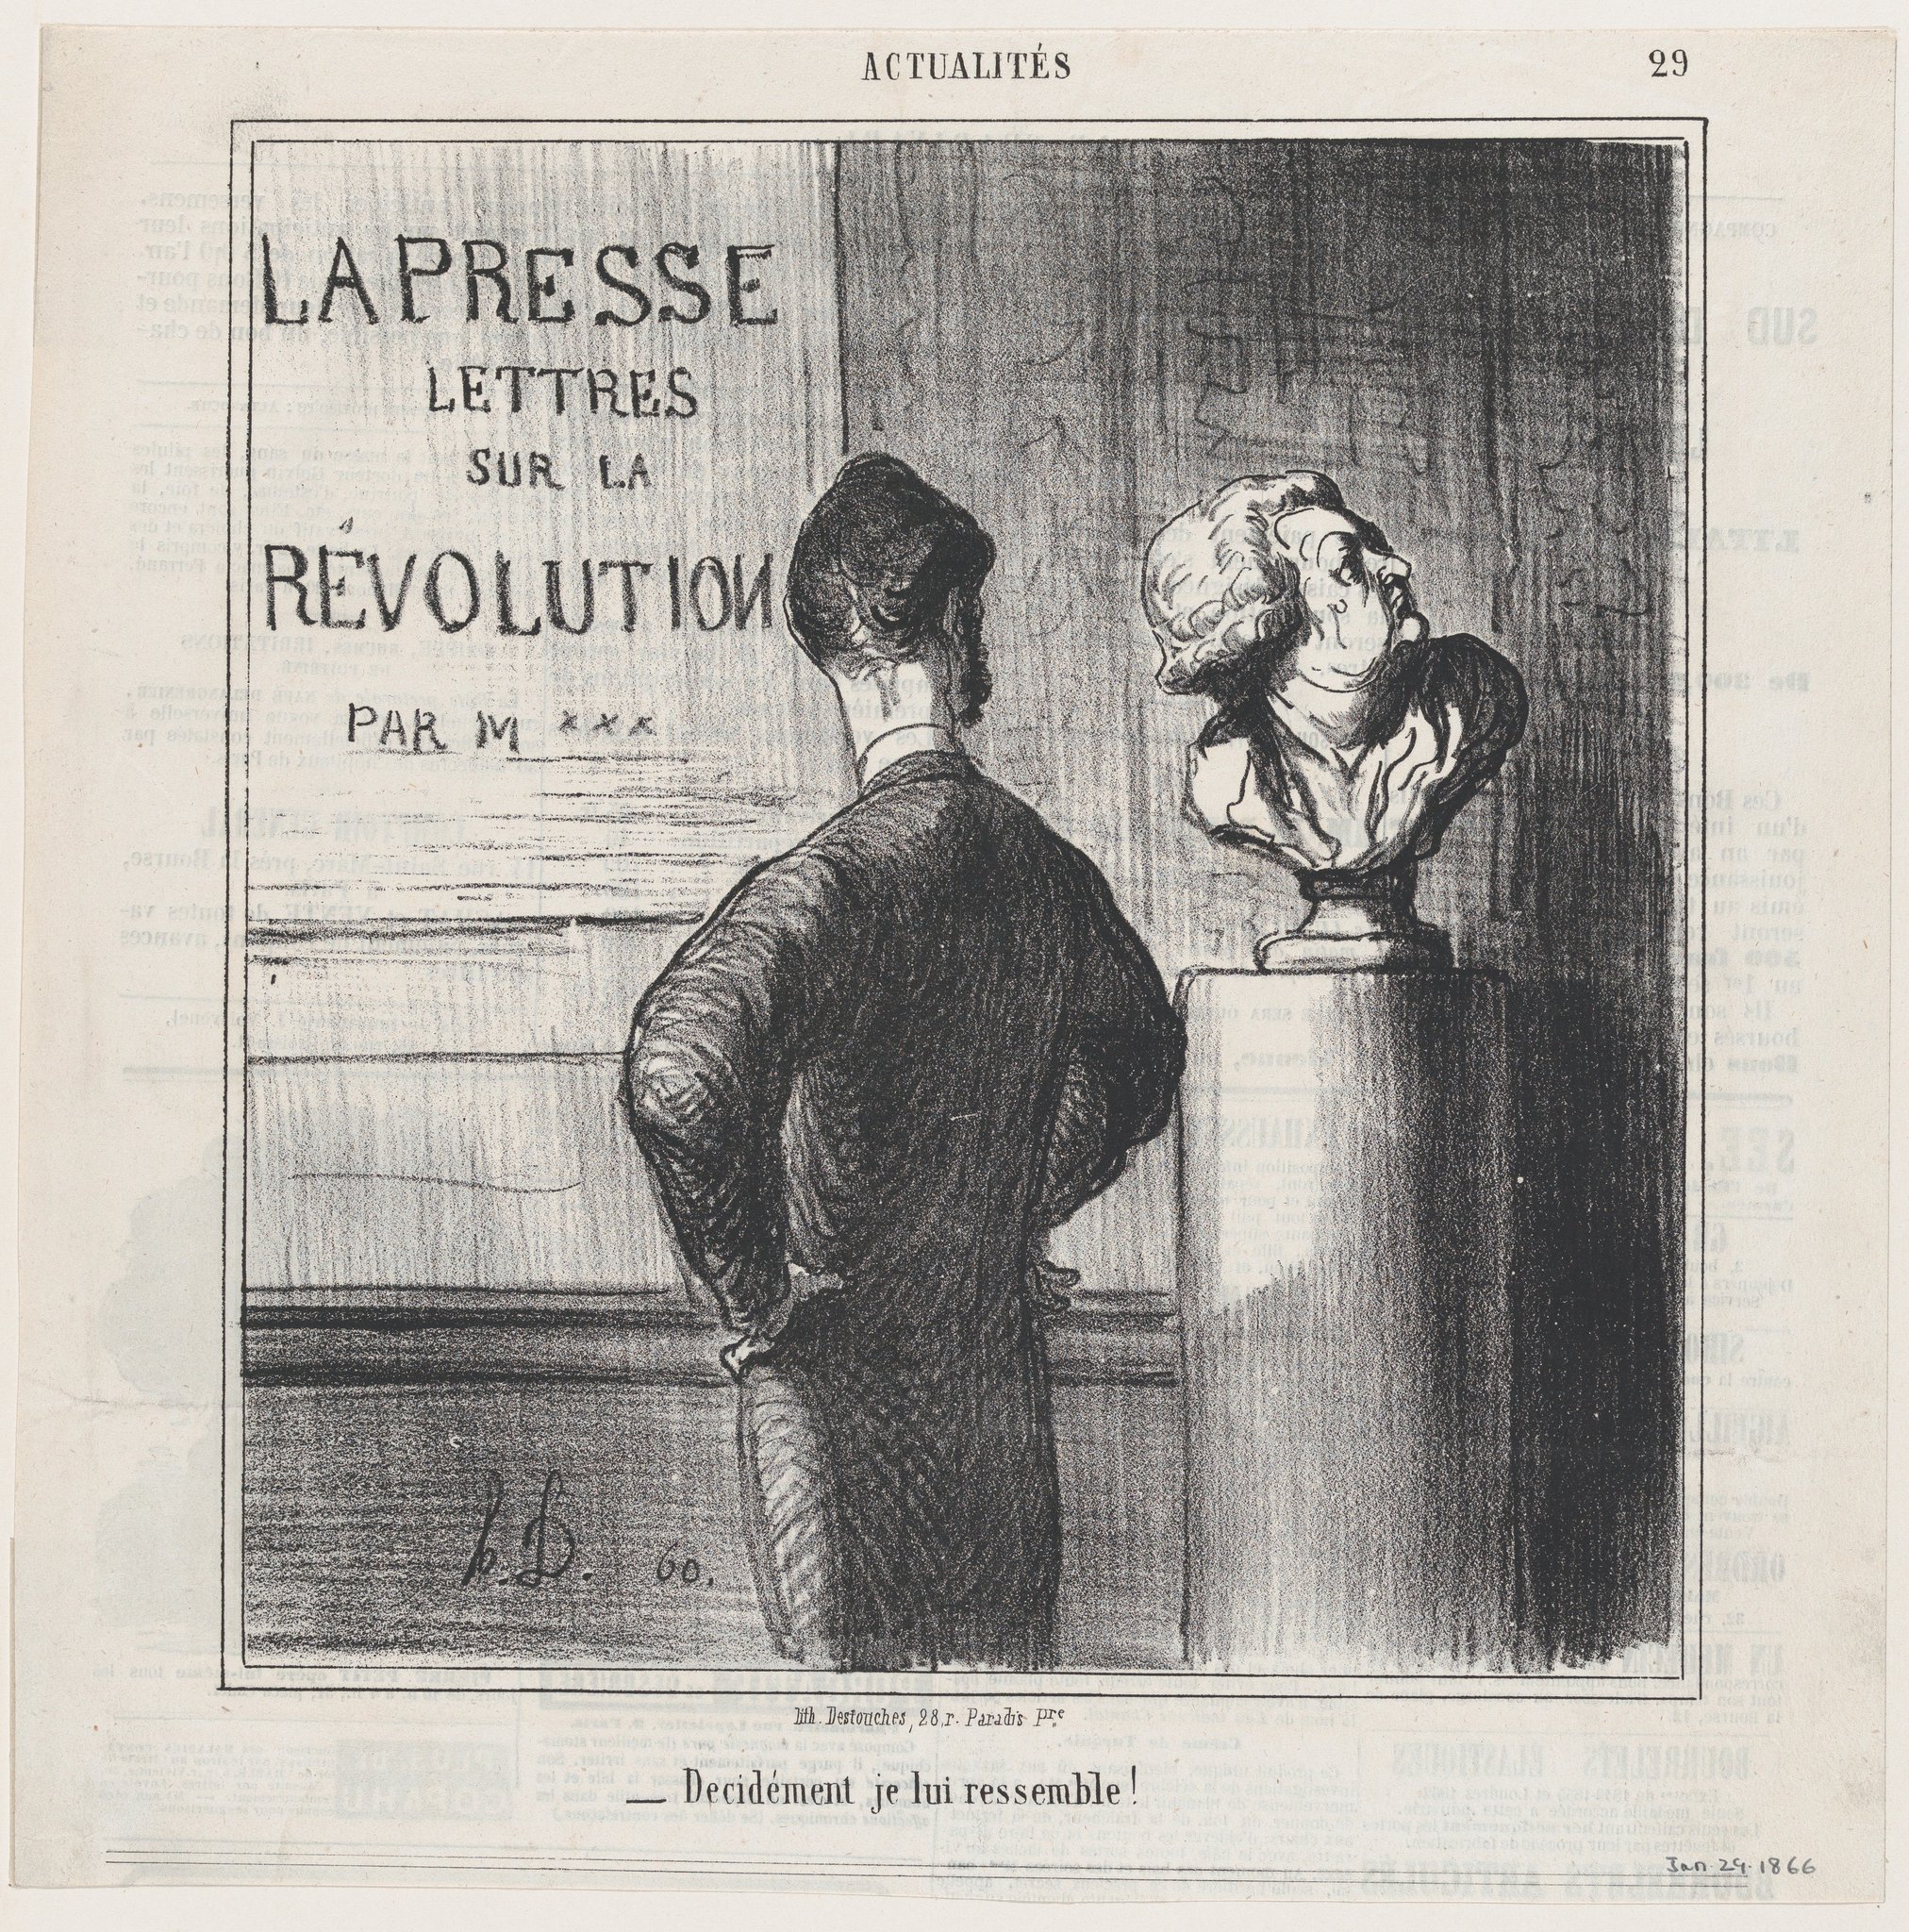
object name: print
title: Obviously I resemble him!, from 'News of the day,' published in Le Charivari, January 29, 1866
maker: honoré daumier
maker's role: artist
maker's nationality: french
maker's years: 1808-1879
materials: paper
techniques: lithograph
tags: satire,sculpture,men